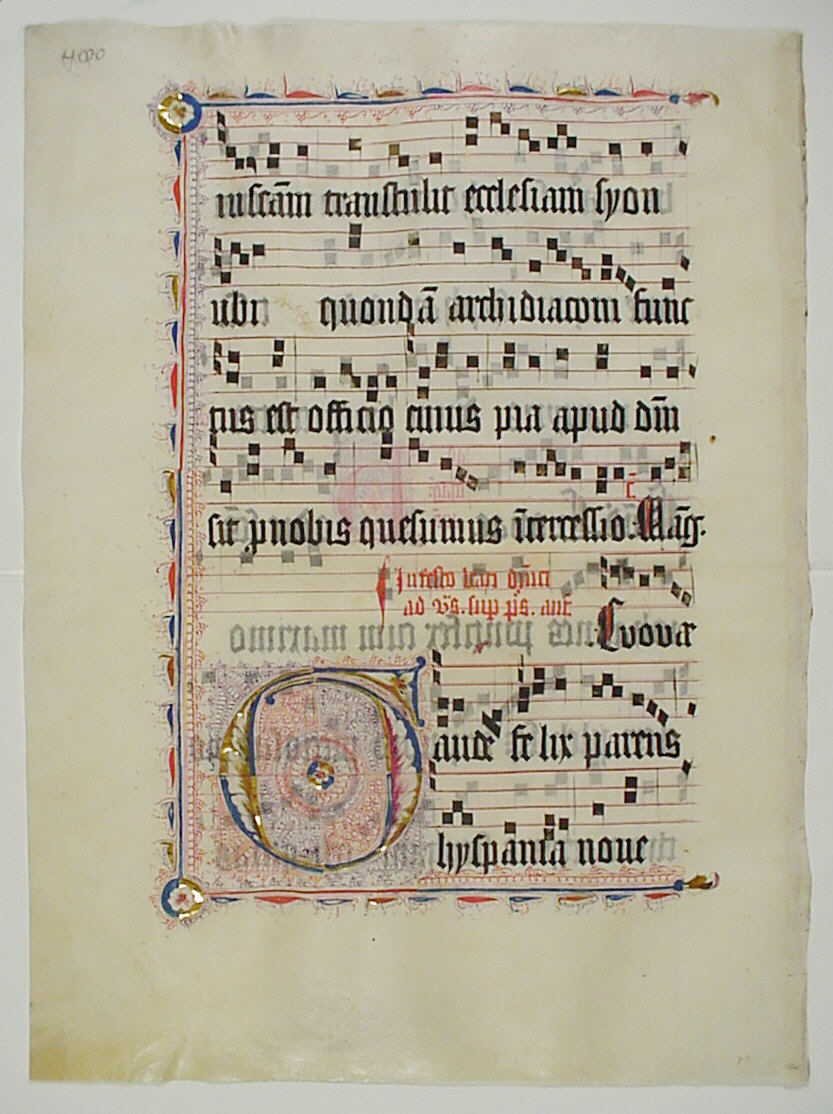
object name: antiphonary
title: Manuscript Leaf with Initial G, from an Antiphonary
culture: german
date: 1426-1450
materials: ink, metal leaf, parchment, paint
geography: germany